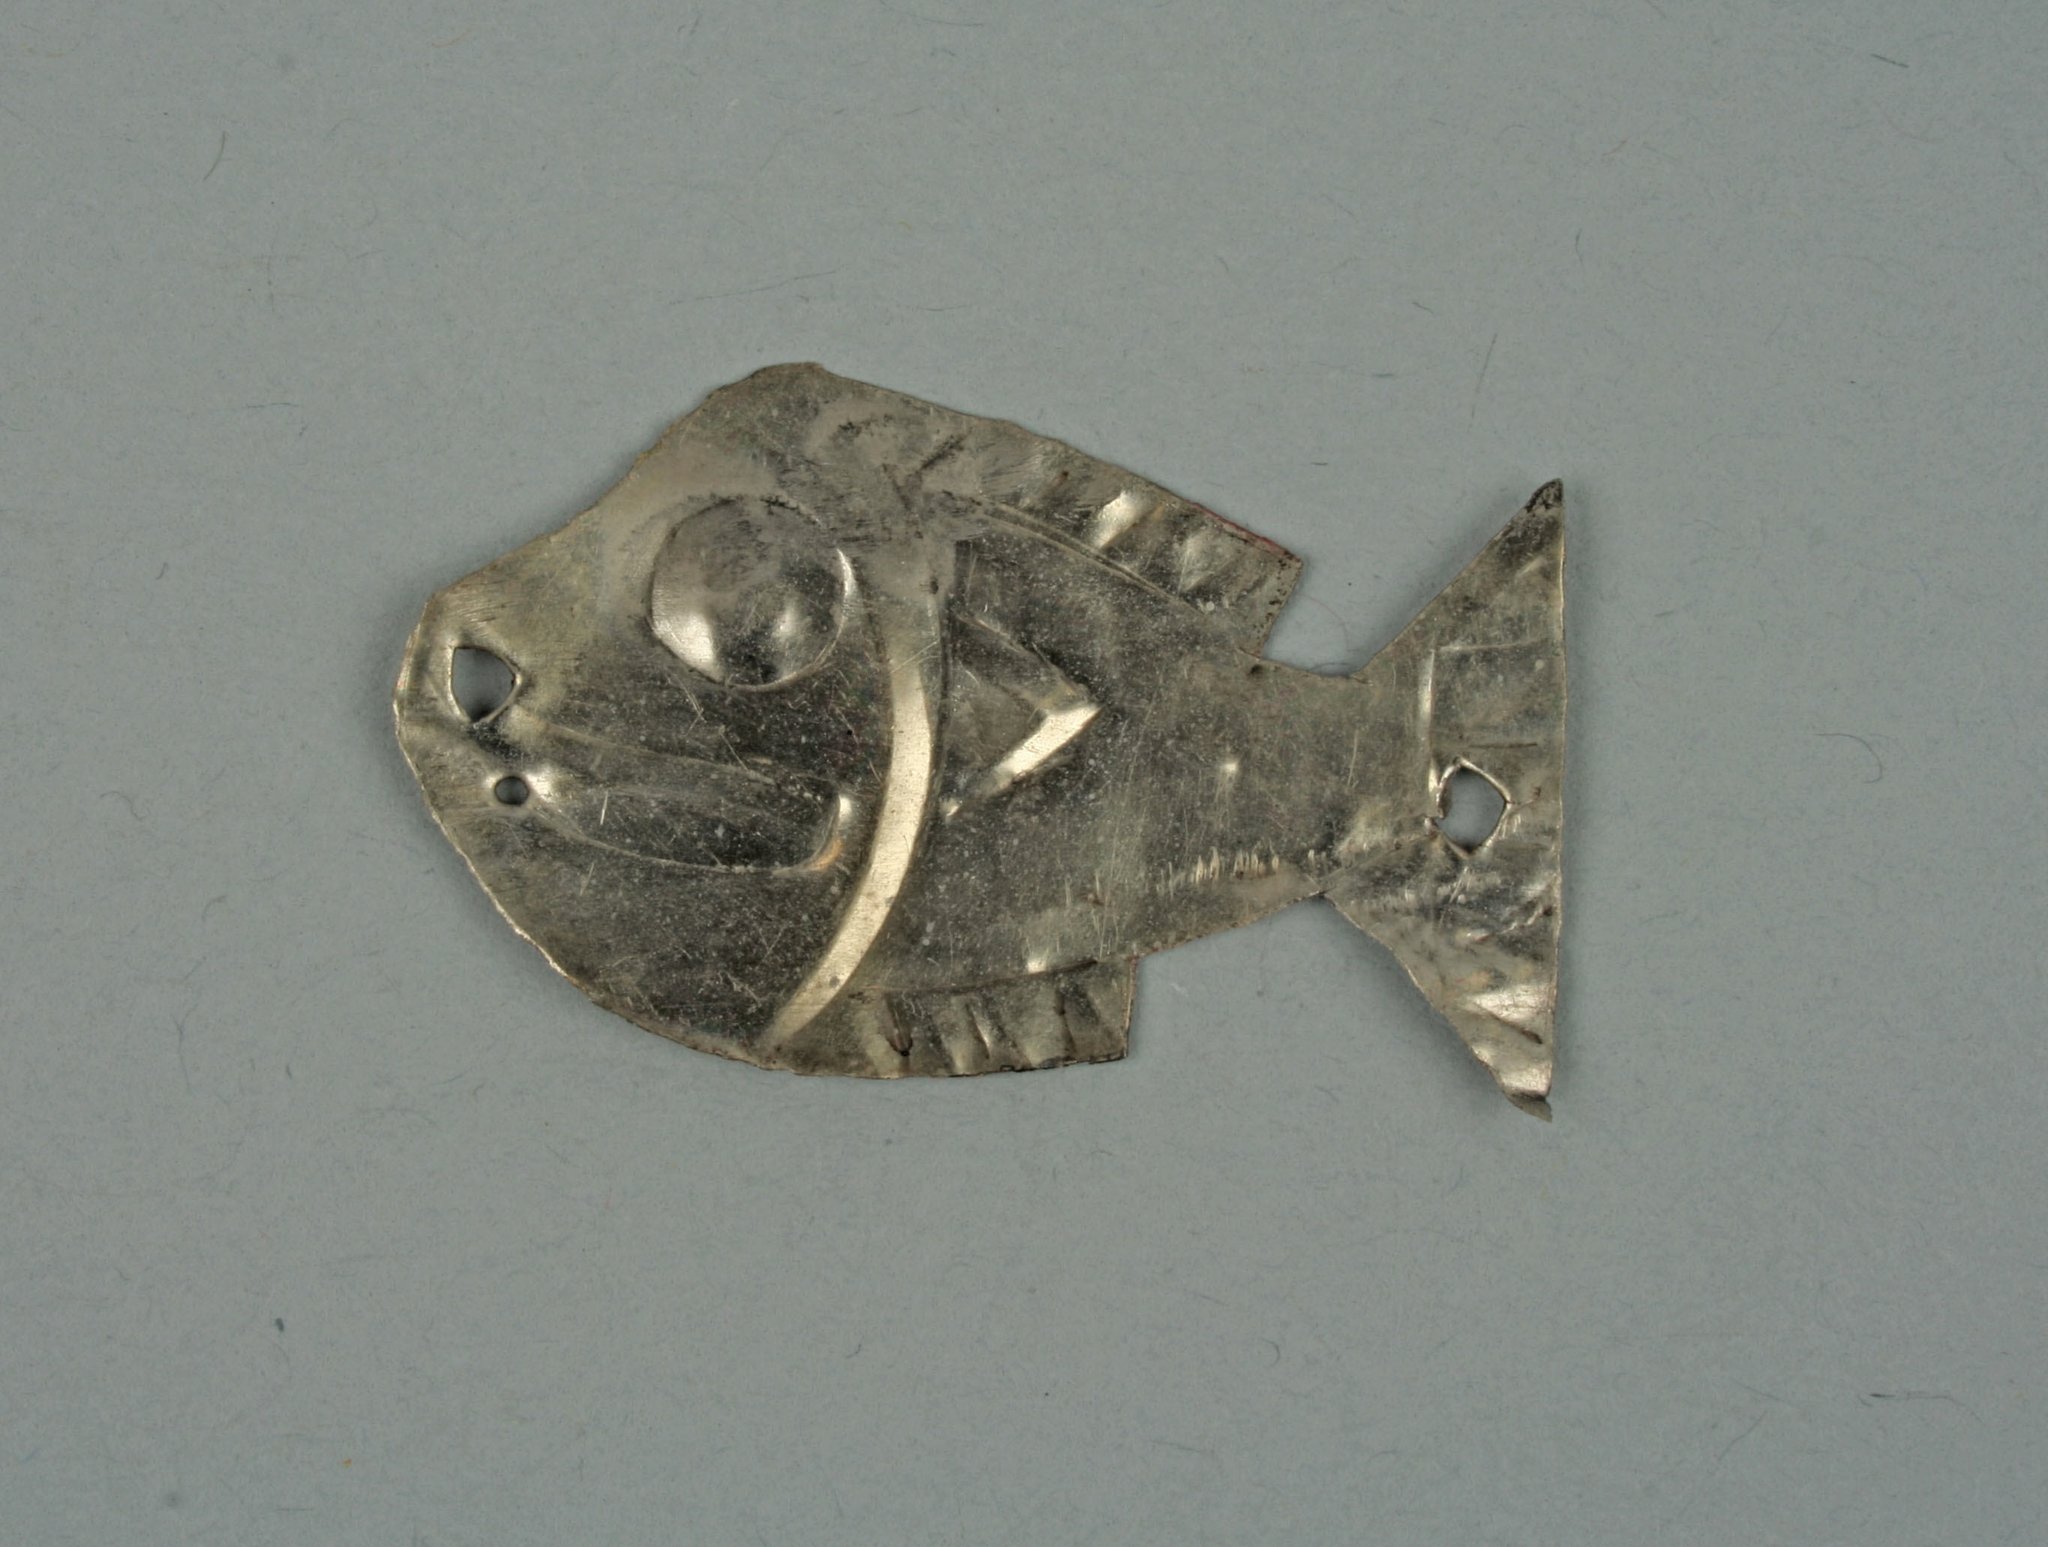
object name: ornament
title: Fish Ornament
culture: peruvian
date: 1001-1200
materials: silver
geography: peru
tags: fish